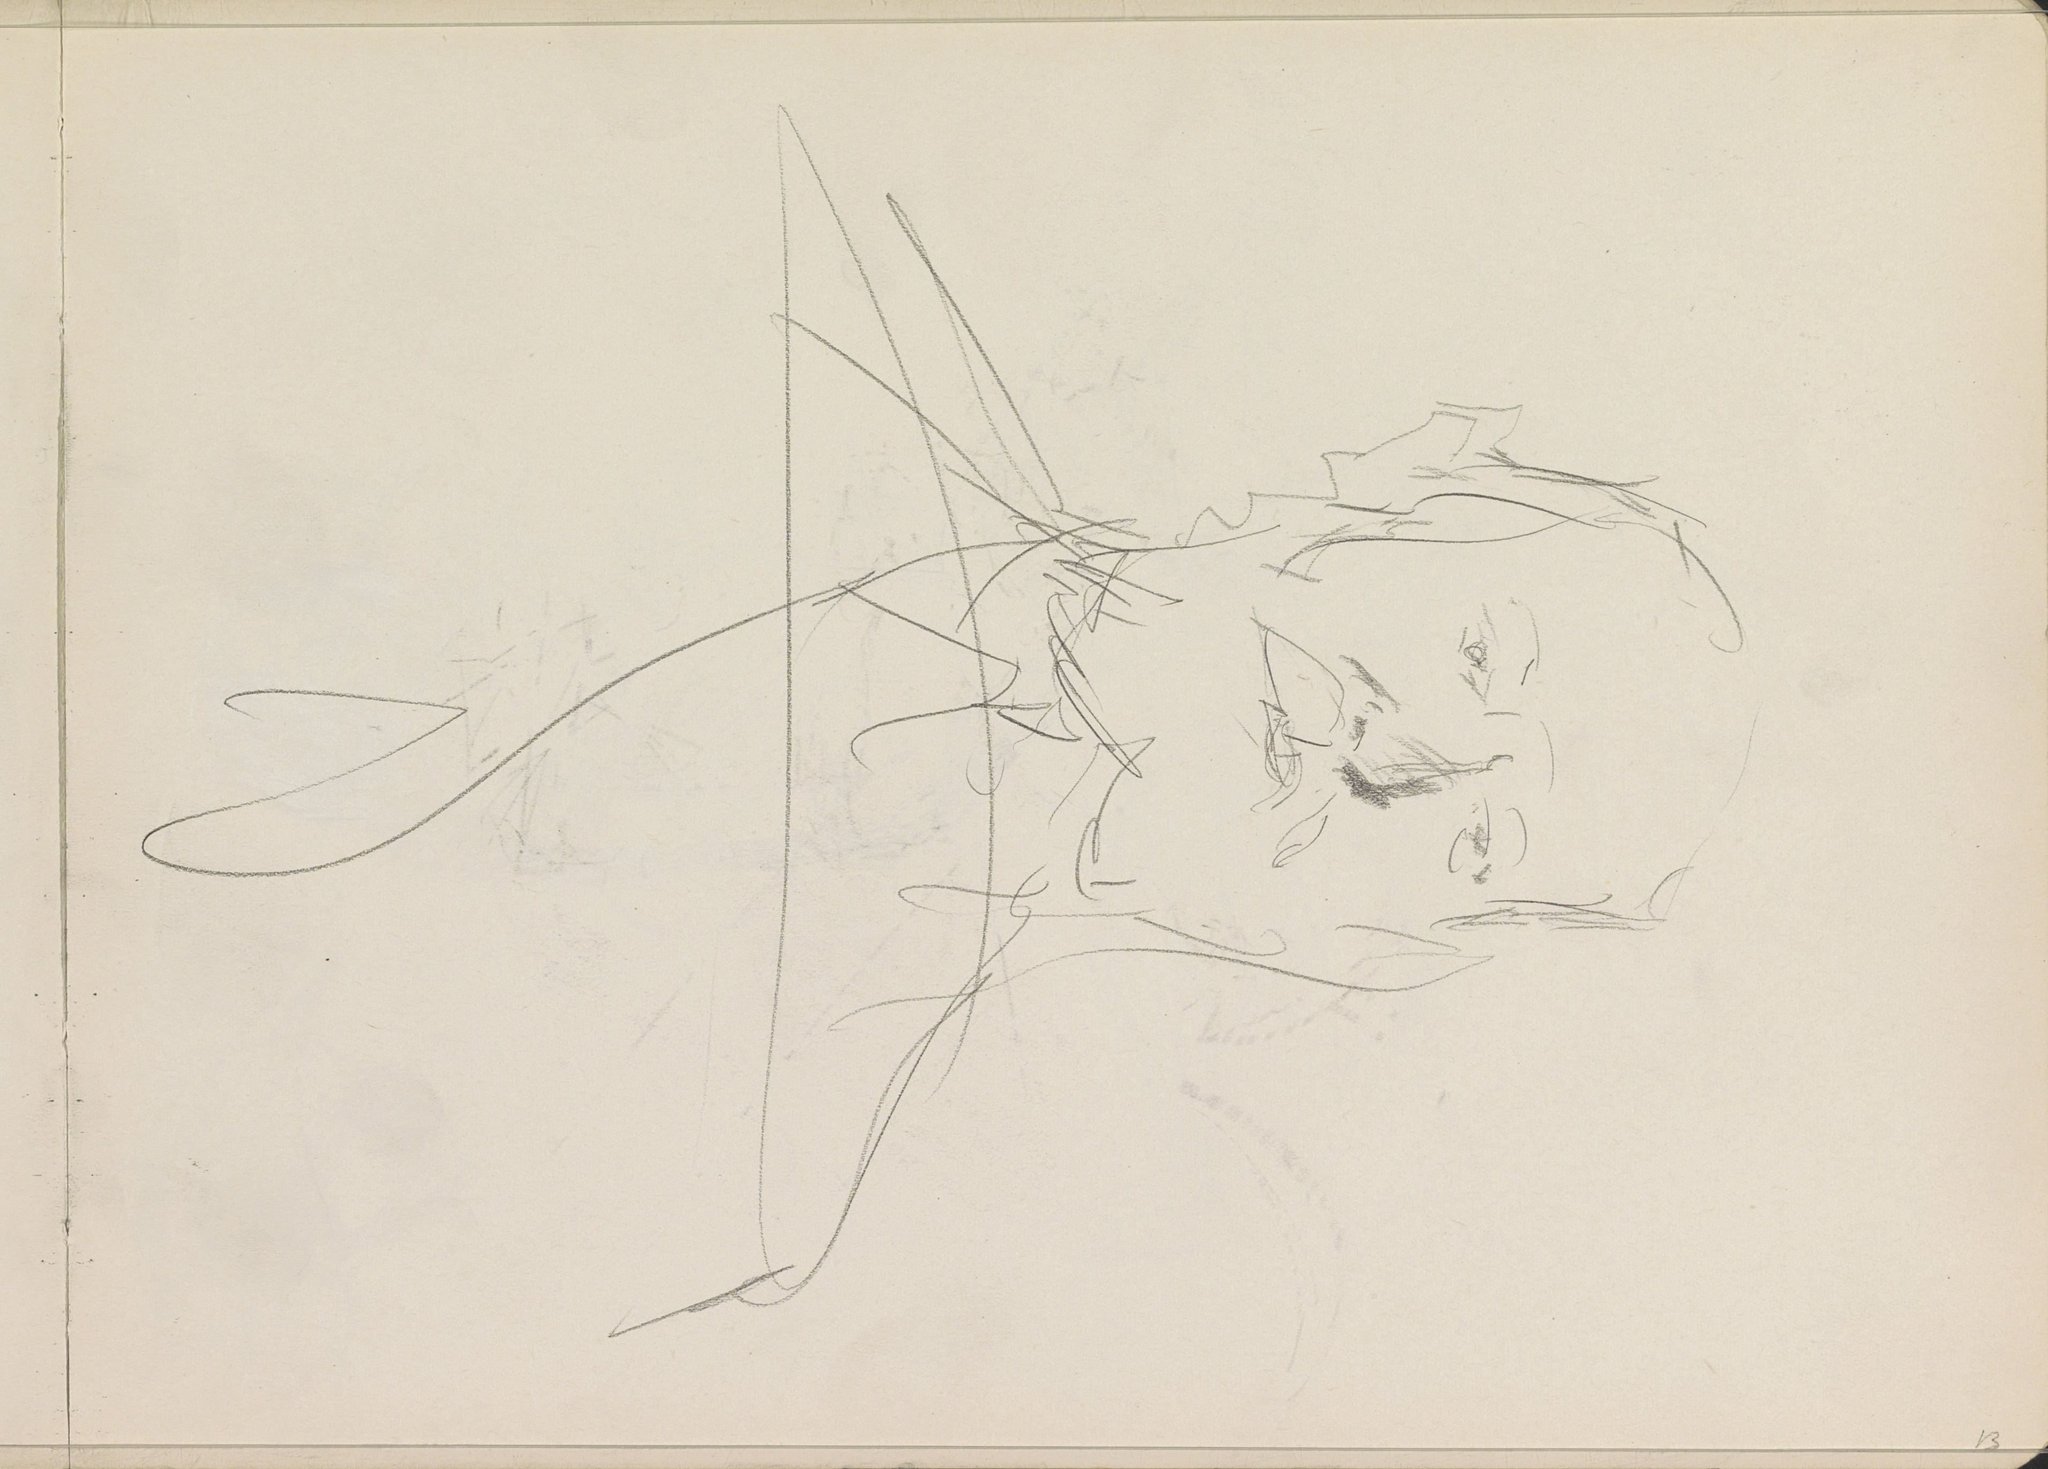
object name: sketchbook leaf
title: Mannenhoofd met snor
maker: isaac israels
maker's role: draughtsman, painter, print maker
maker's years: 1865-1934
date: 1915-1934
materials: paper, pencil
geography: the hague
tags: head (human)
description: Blad 13 recto uit schetsboek VI met 33 bladen.